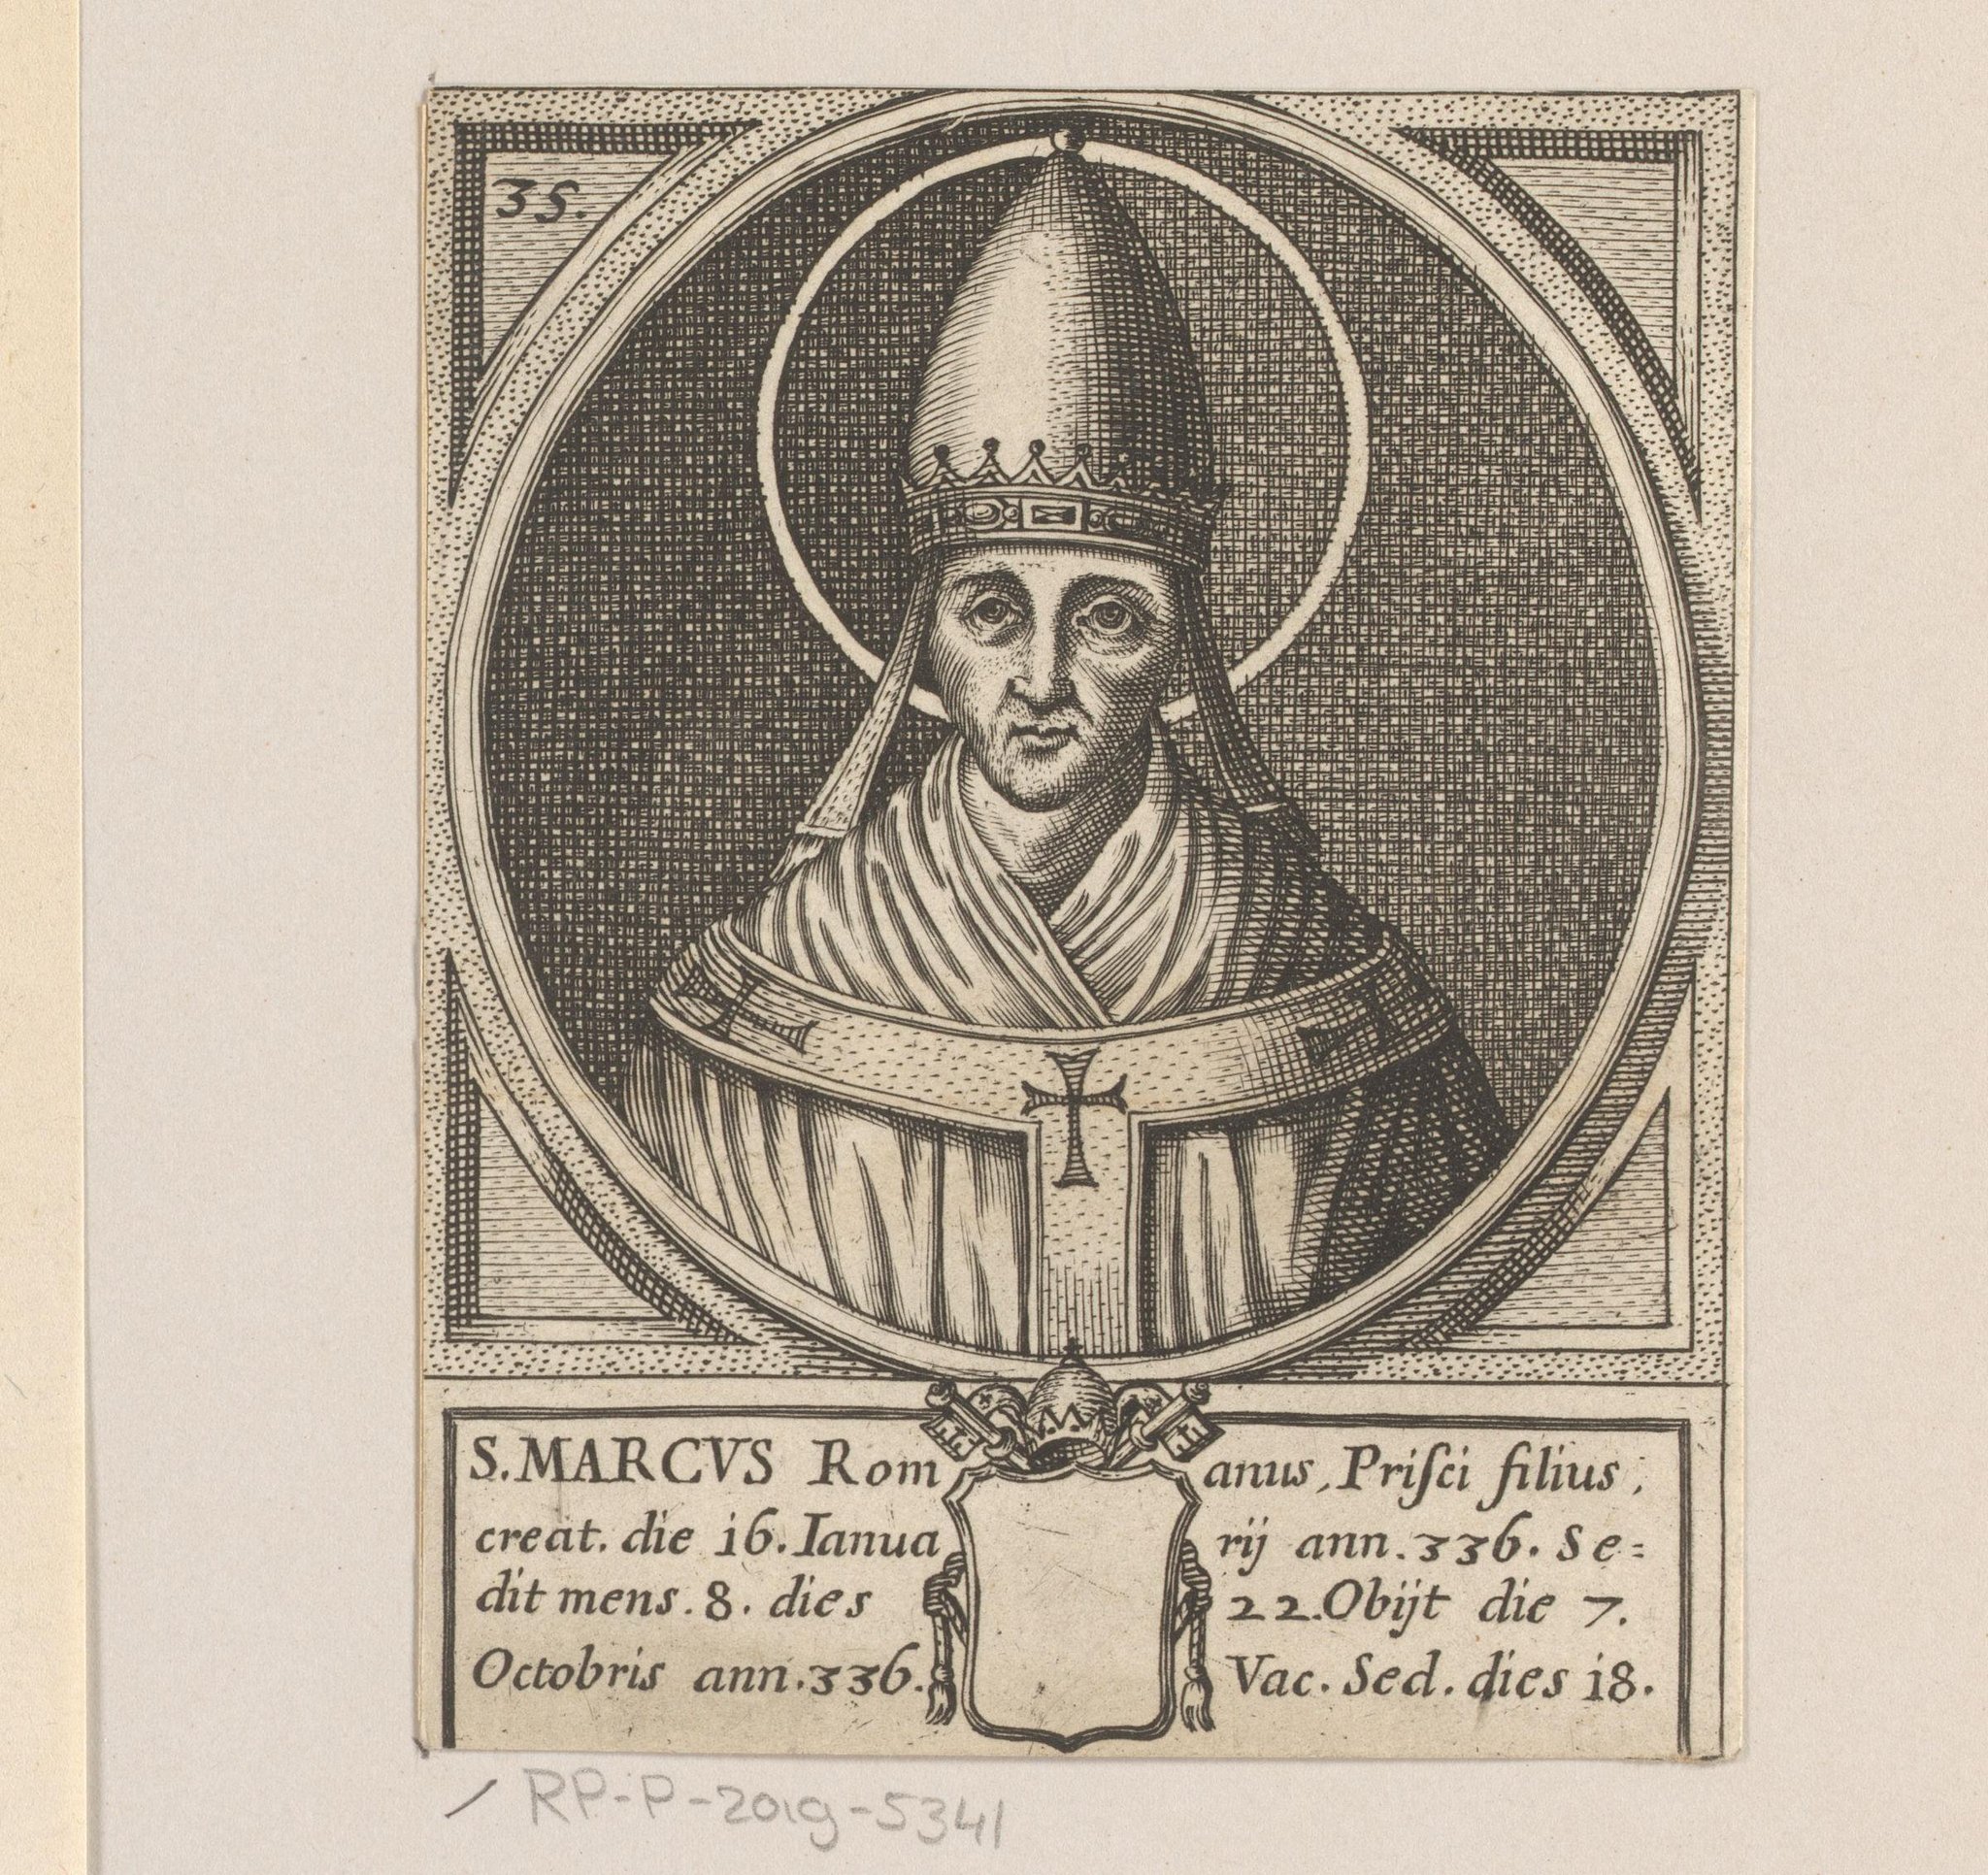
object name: print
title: Portret van paus Marcus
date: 1675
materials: paper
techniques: engraving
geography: rome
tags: historical persons, pope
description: Portret afkomstig uit een grote prent, bestaande uit 17 bladen die samengevoegd konden worden, uitgegeven door Giovanni Giacomo de' Rossi in 1675.